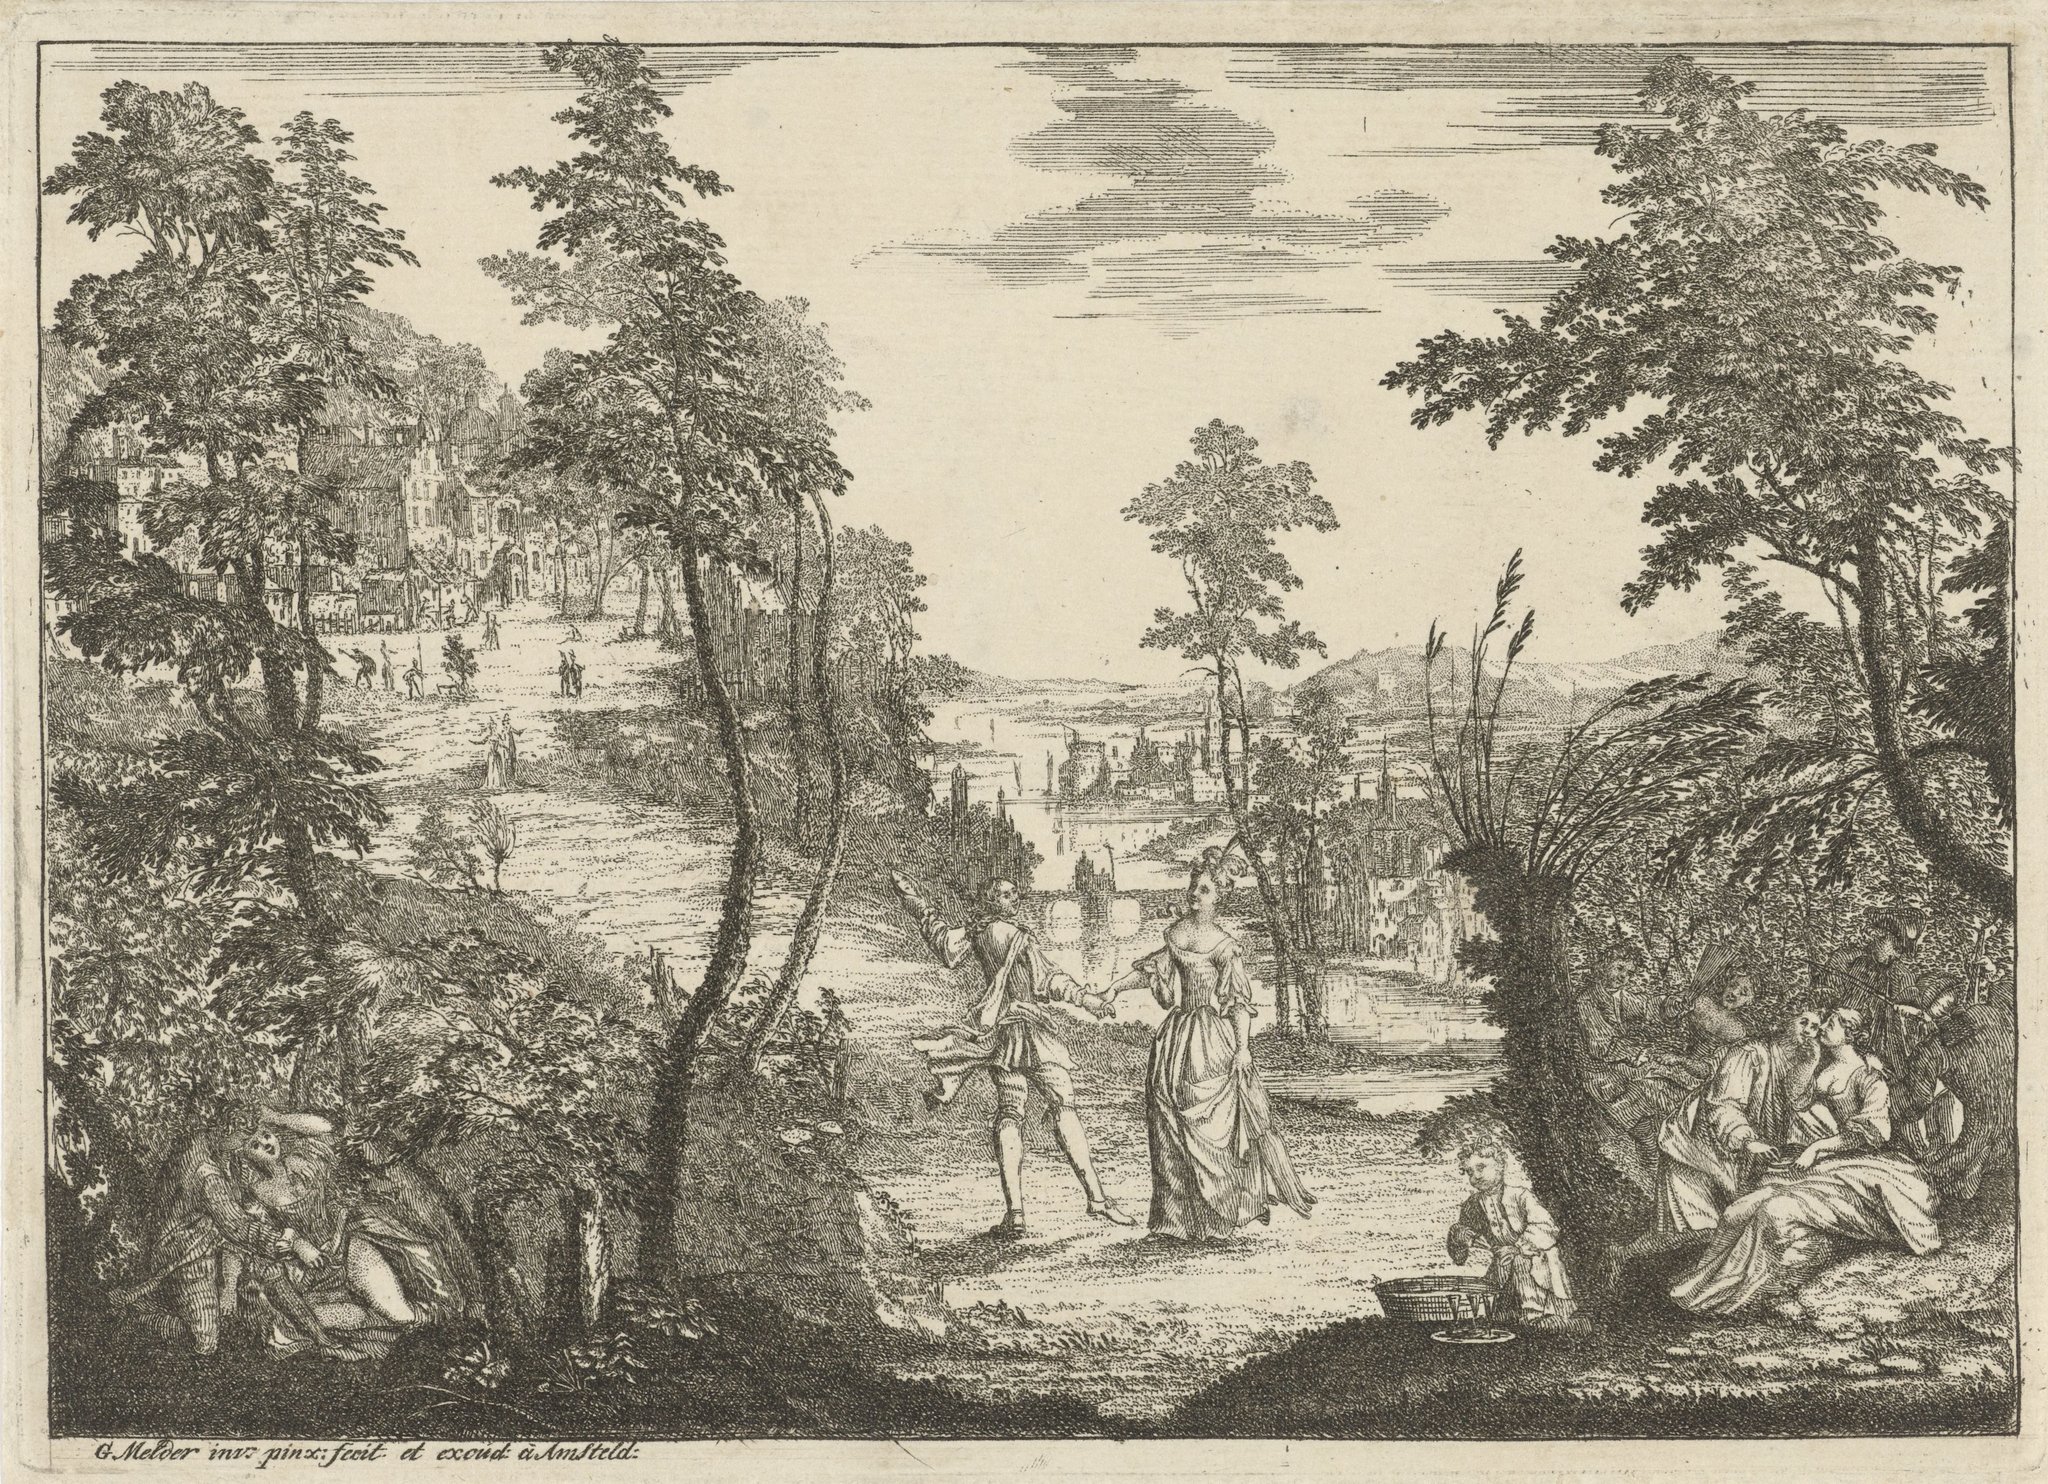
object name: print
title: Landschap met vrijende paartjes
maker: gerard melder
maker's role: painter, print maker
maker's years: 1693-1754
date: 1703-1754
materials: paper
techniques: etching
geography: amsterdam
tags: river, couple of lovers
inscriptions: collector's mark: Lugt 2165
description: In een landschap in het struikgewas verschillende vrijende paartjes. Op de achtergrond een rivier.